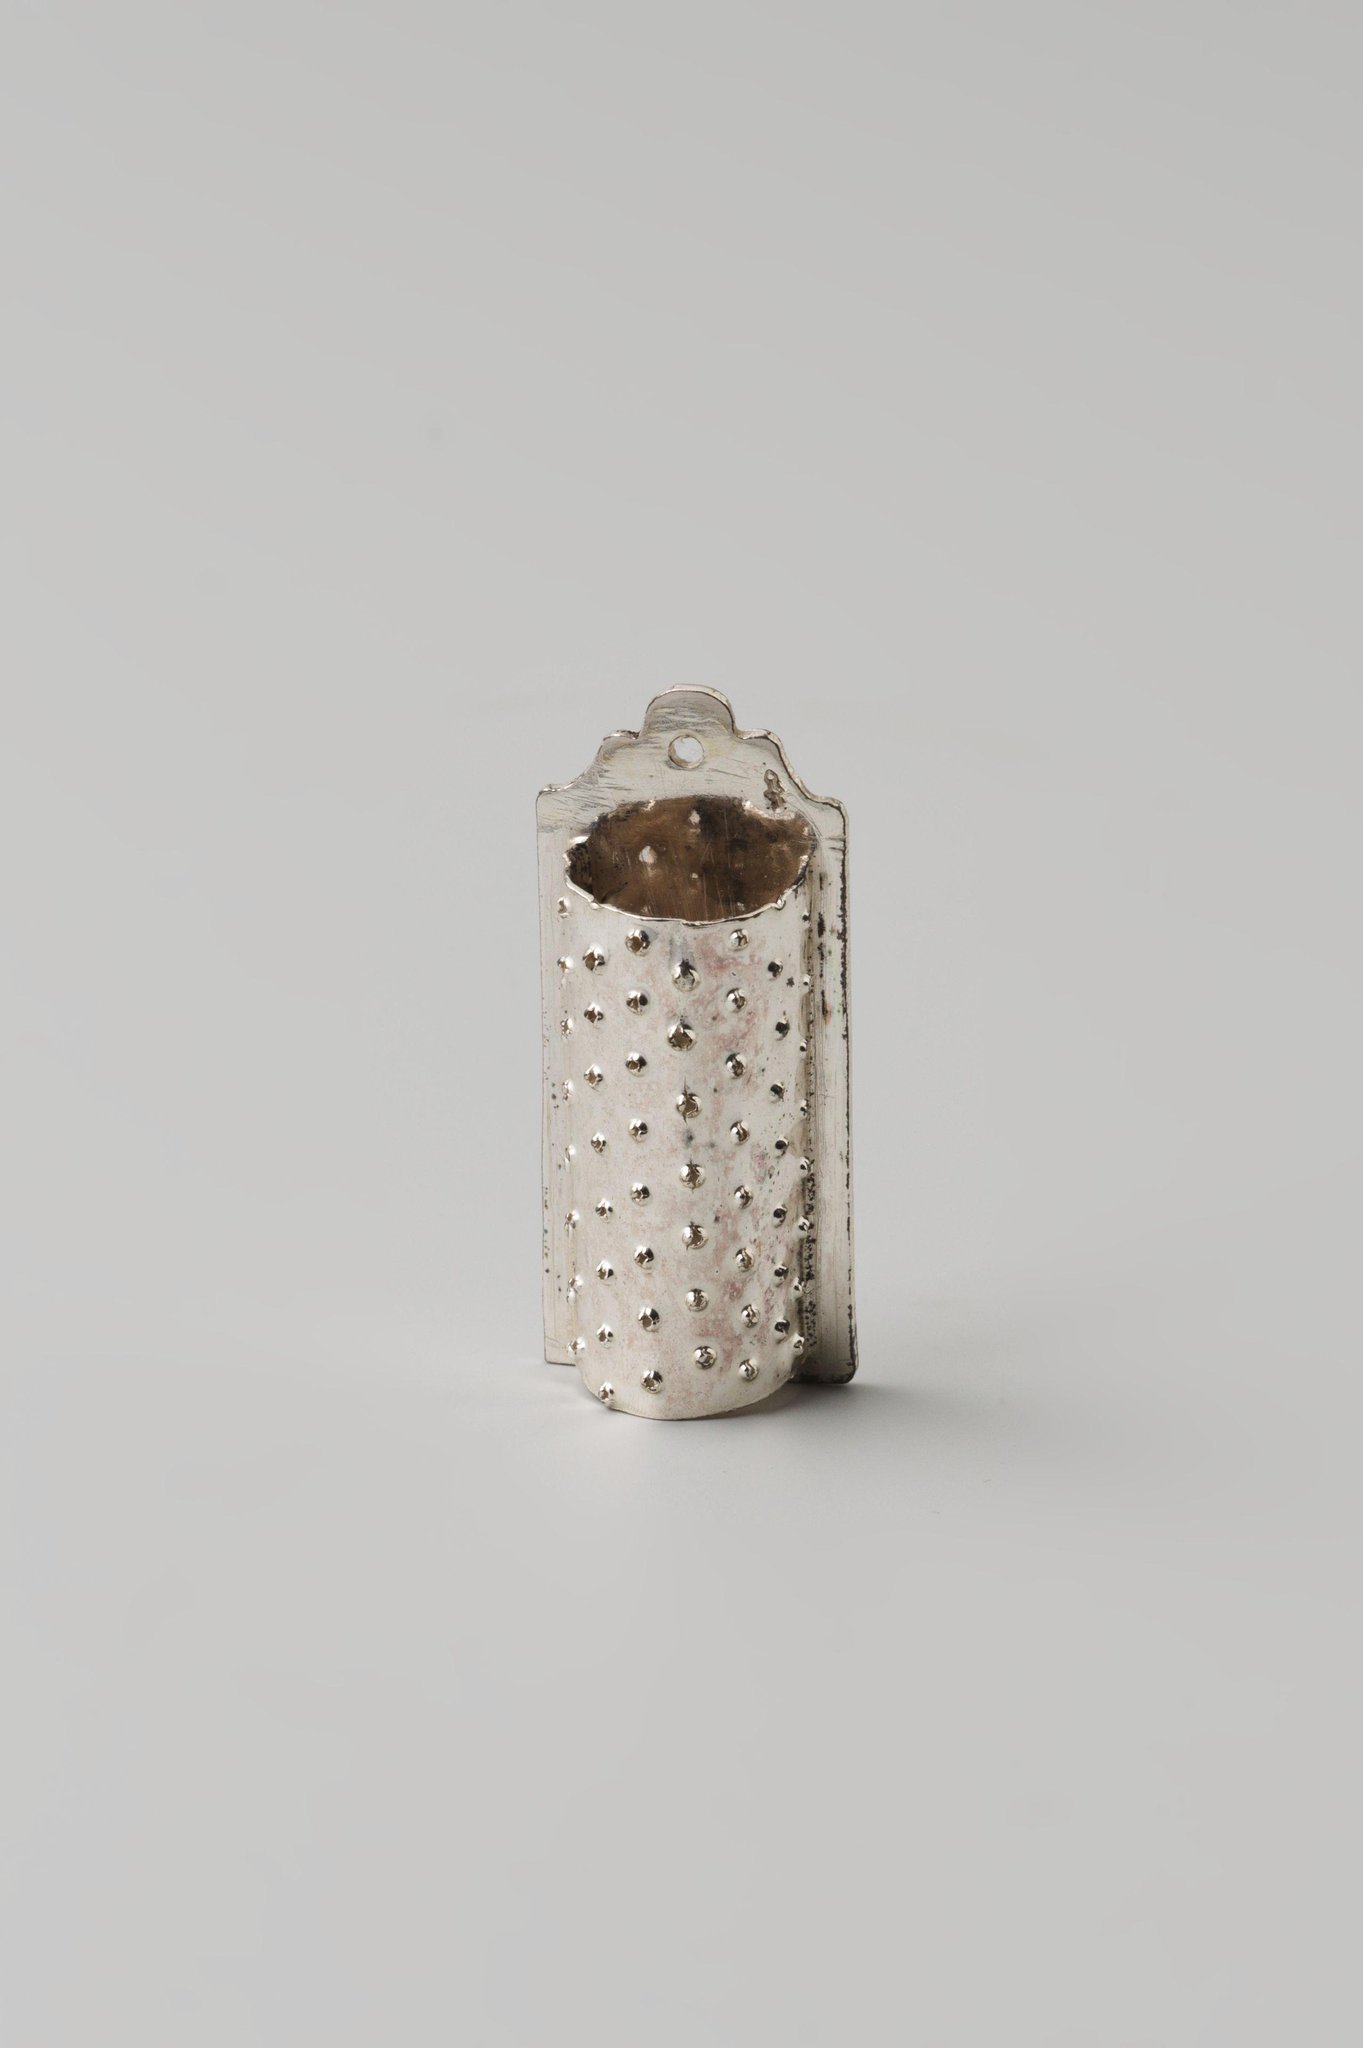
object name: grater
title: Rasp van zilver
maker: Anonymous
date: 1814-1906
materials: silver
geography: netherlands